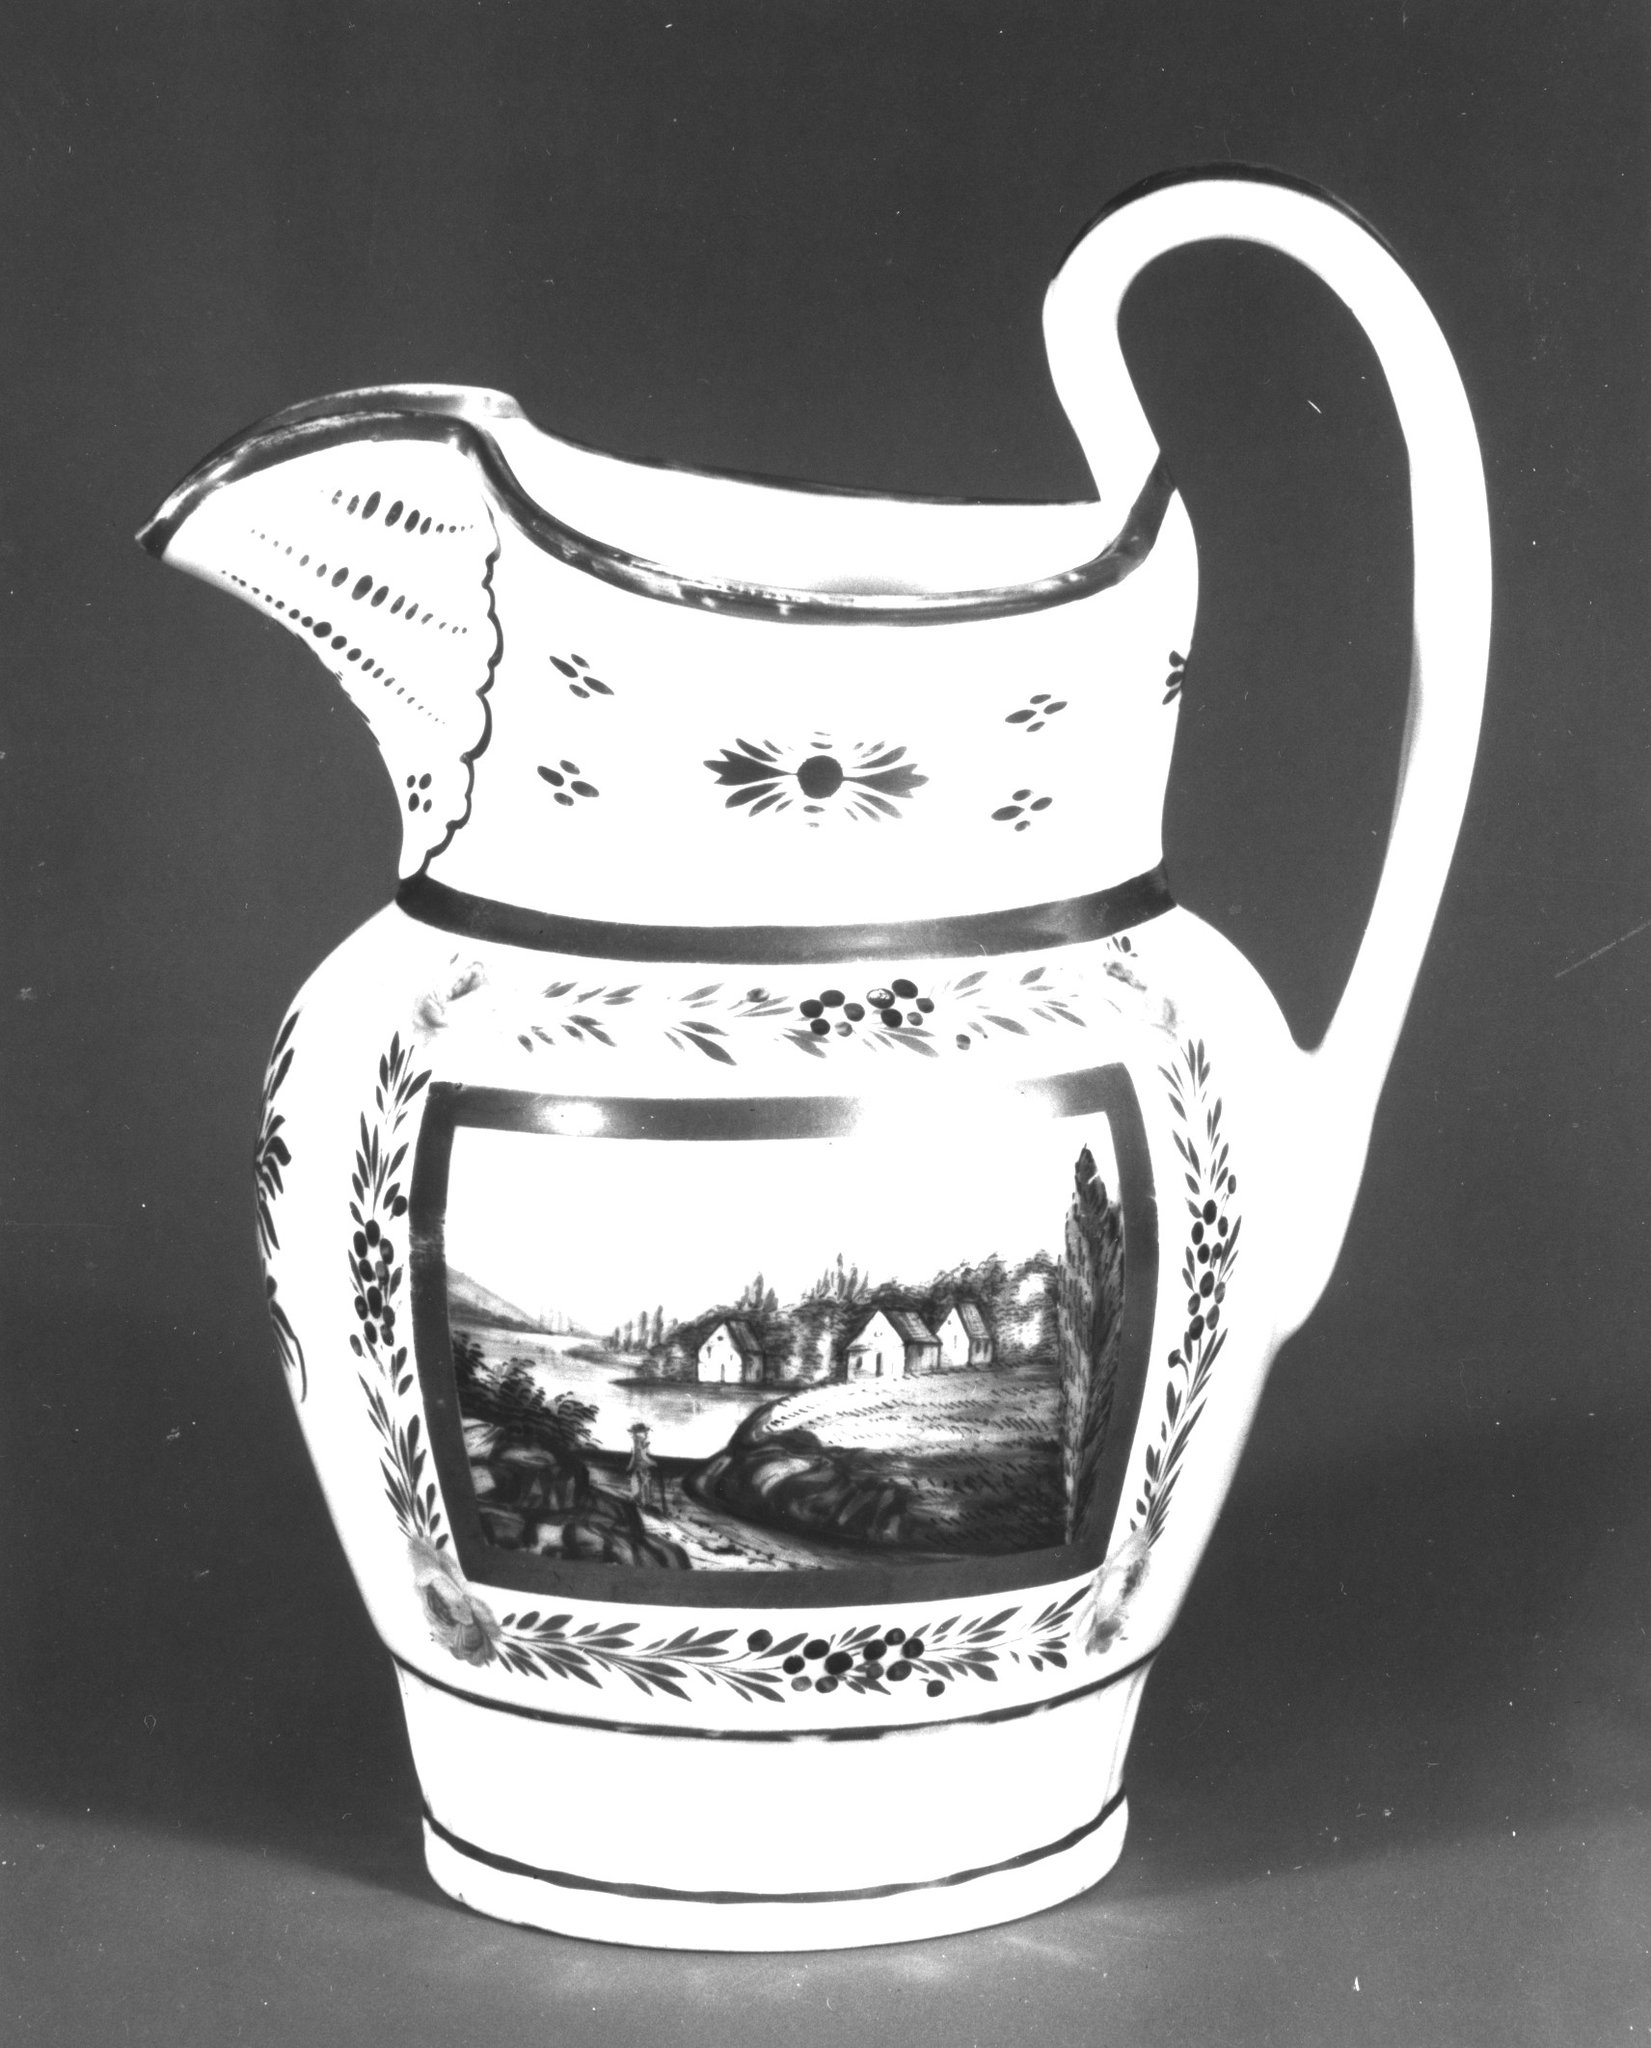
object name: pitcher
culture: american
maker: tucker factory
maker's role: maker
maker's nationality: american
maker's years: 1826-1838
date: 1826-1838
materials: porcelain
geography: united states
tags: landscapes